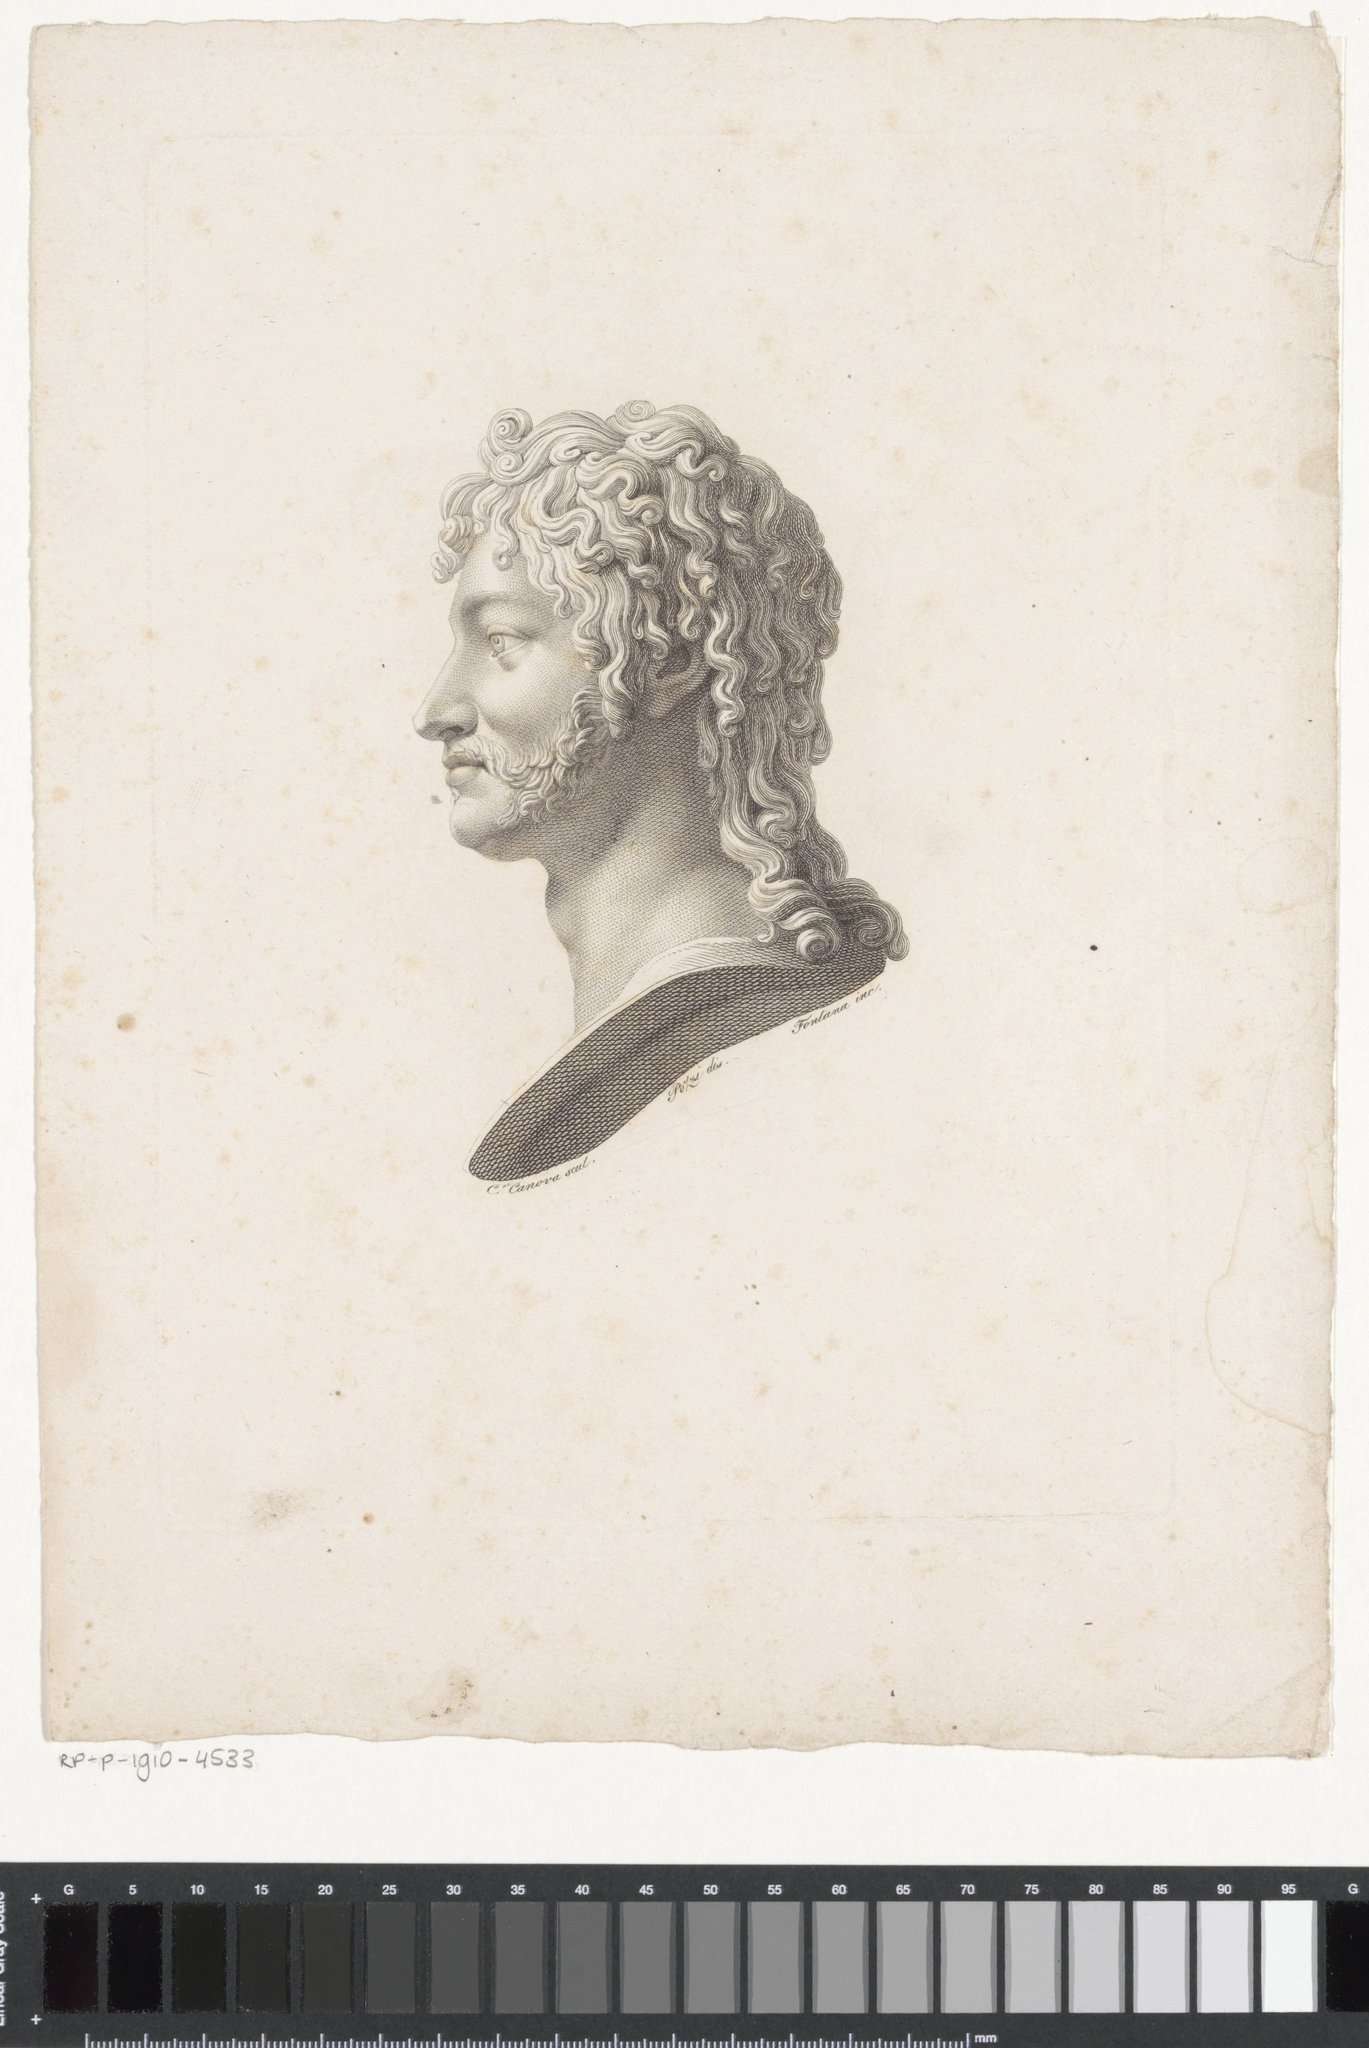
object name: print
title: Portretbuste van Joachim Murat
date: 1773-1837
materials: paper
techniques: engraving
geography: italy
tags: historical persons, piece of sculpture, reproduction of a piece of sculpture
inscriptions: collector's mark: Lugt 2228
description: Het originele sculptuur door Canova staat in het Museo Nazionale di Capodimonte te Napels.